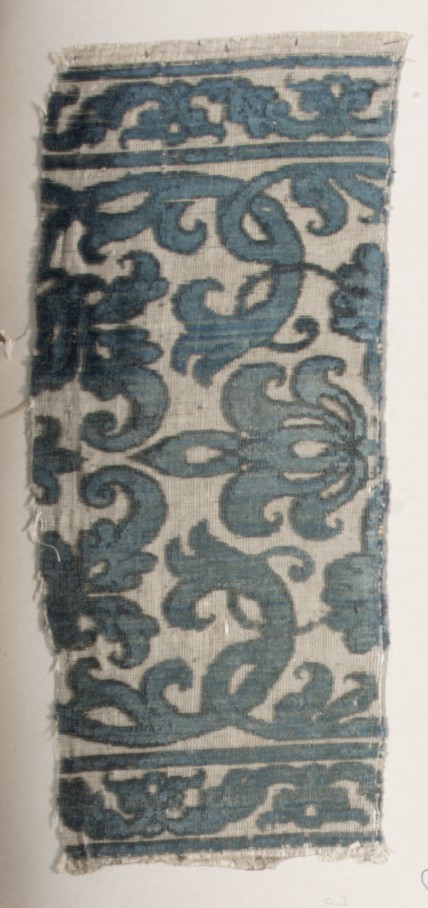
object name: fragment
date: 1501-1700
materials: metal thread, silk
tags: flowers